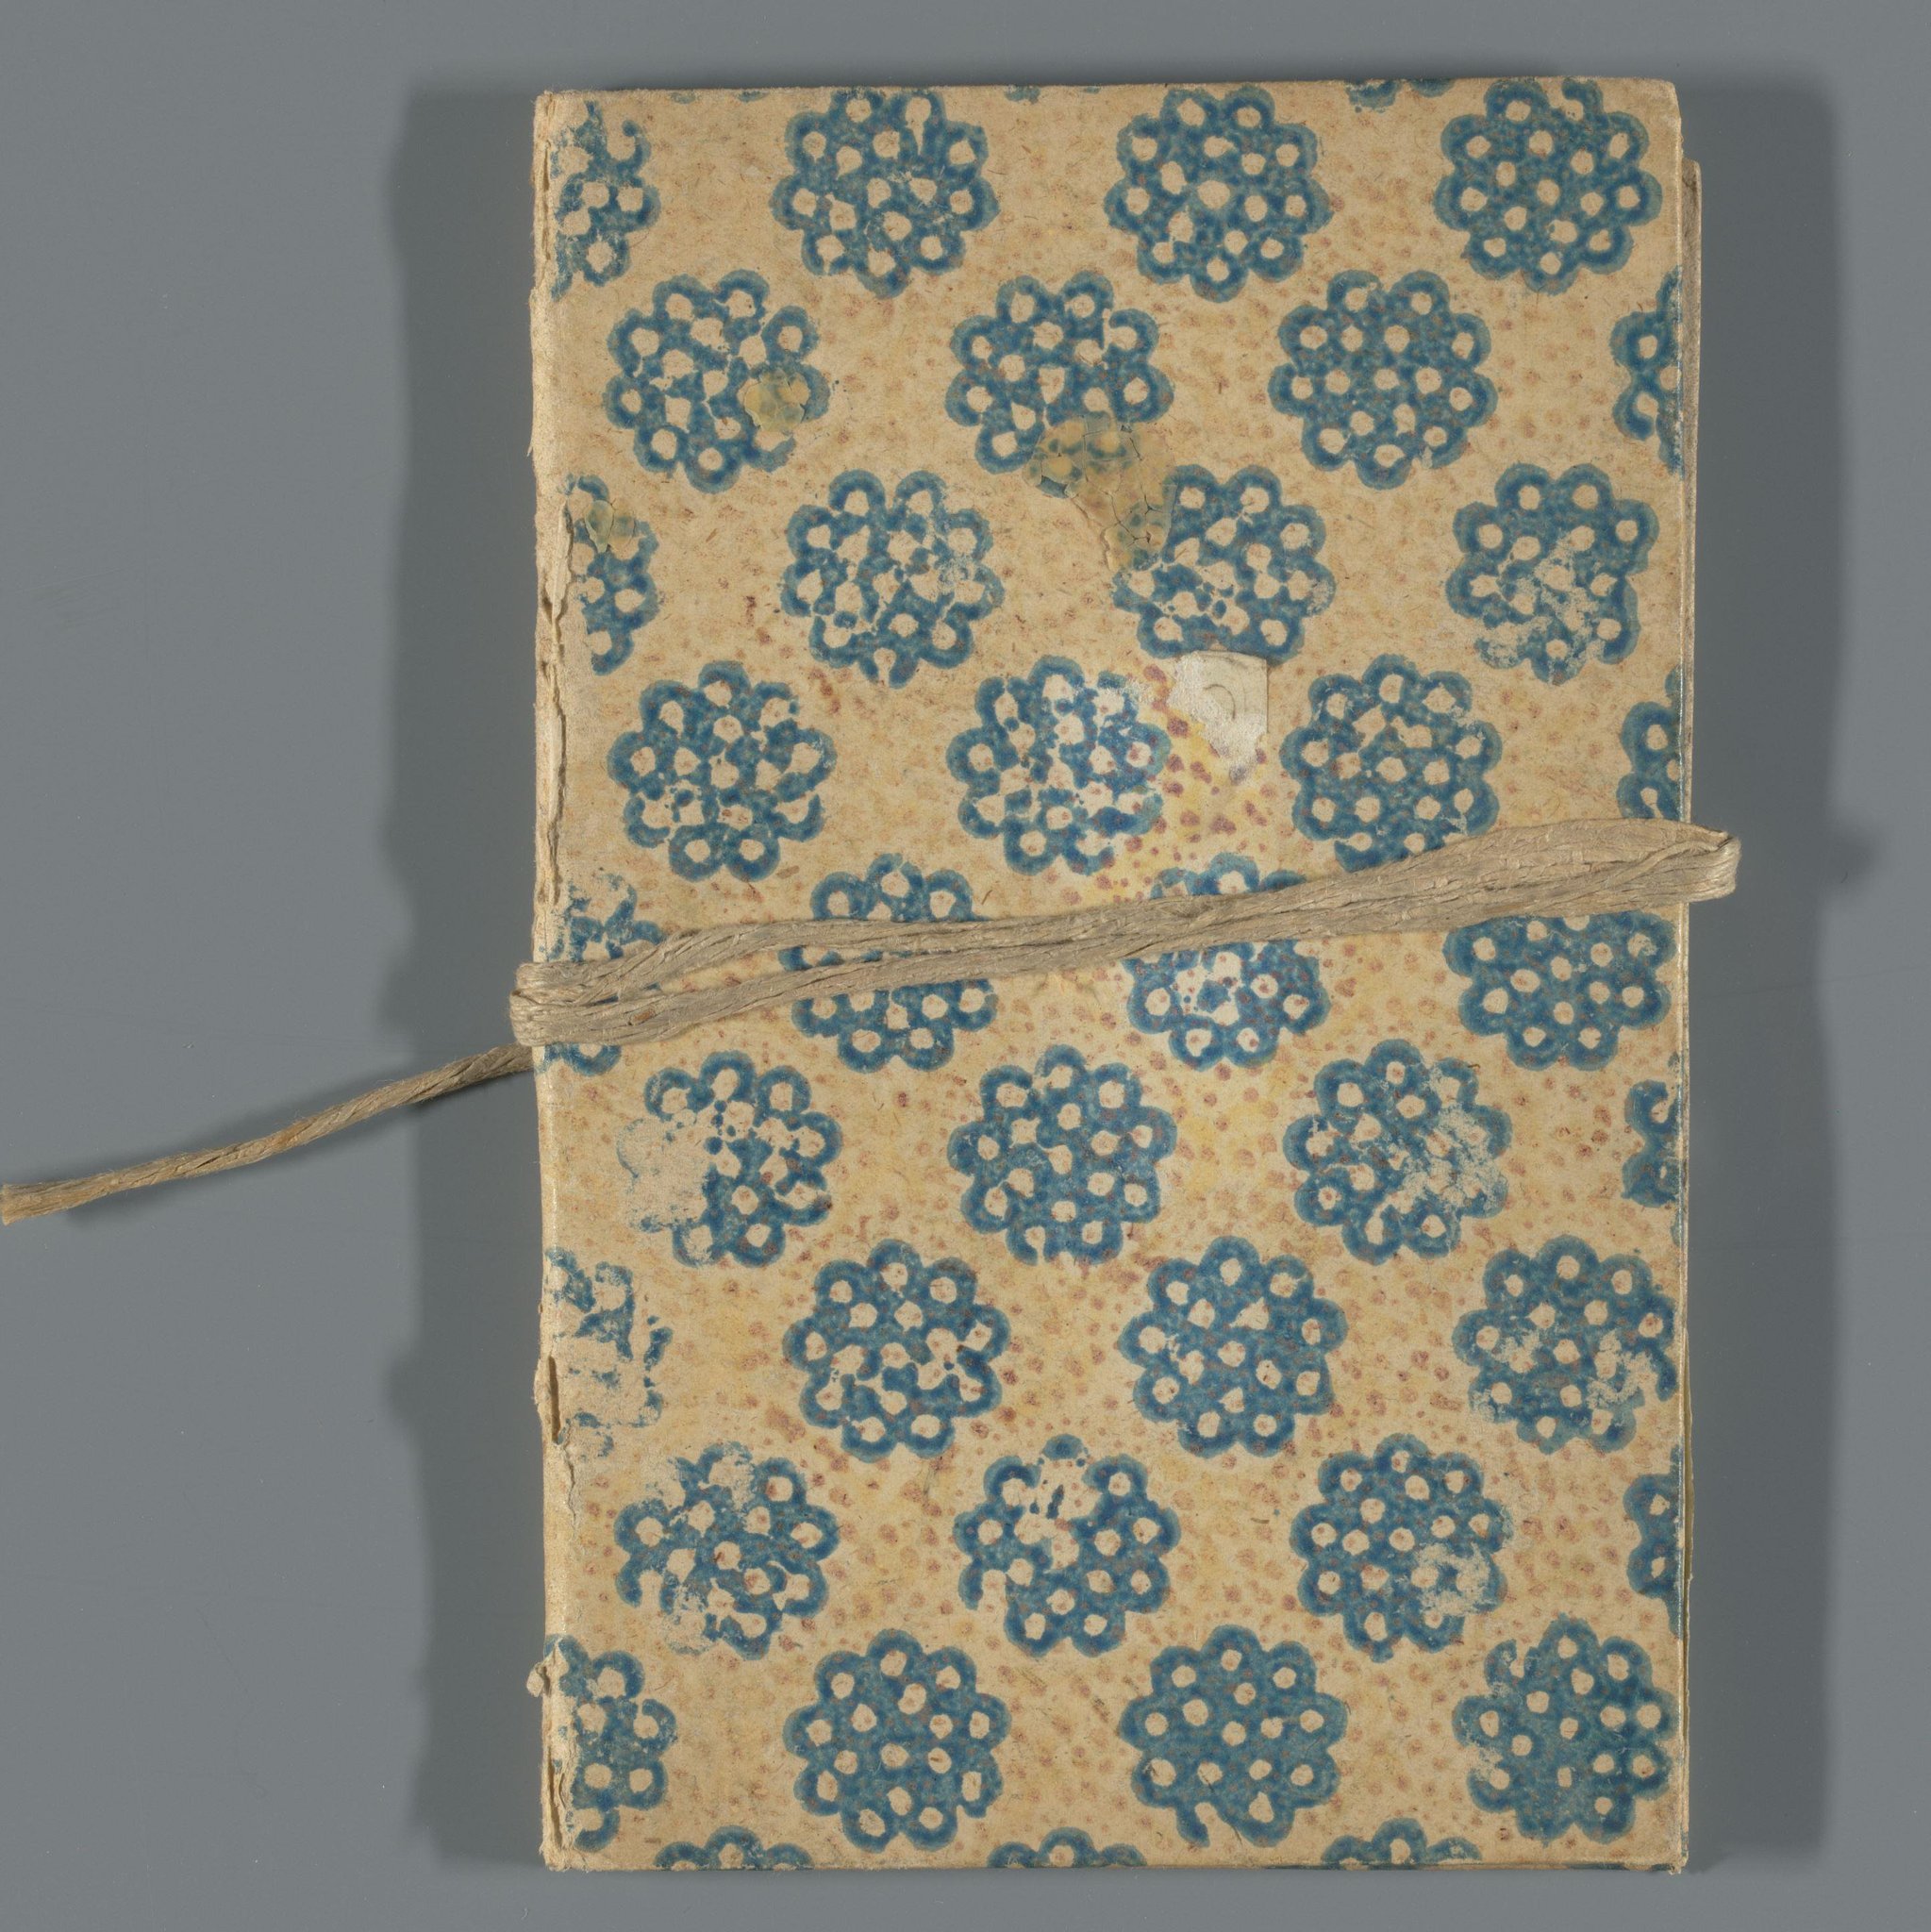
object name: folder container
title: Map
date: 1700-1800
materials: cardboard, paper, textile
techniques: colour, printing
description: Eén van drie mapjes, waarvan twee (A en B) met titel, waarin kaartjes, gedrukt en vervolgens ingekleurd, met 'toneelscènes' in diverse landschappen; enkele vormen een achter elkaar te zetten serie. De meeste hebben een met pen geschreven nummer. De indruk bestaat dat de juiste volgorde niet meer aanwezig is. De mapjes kunnen met touwtjes worden dichtgebonden. Opmerking: zie NG-1091-A en B.